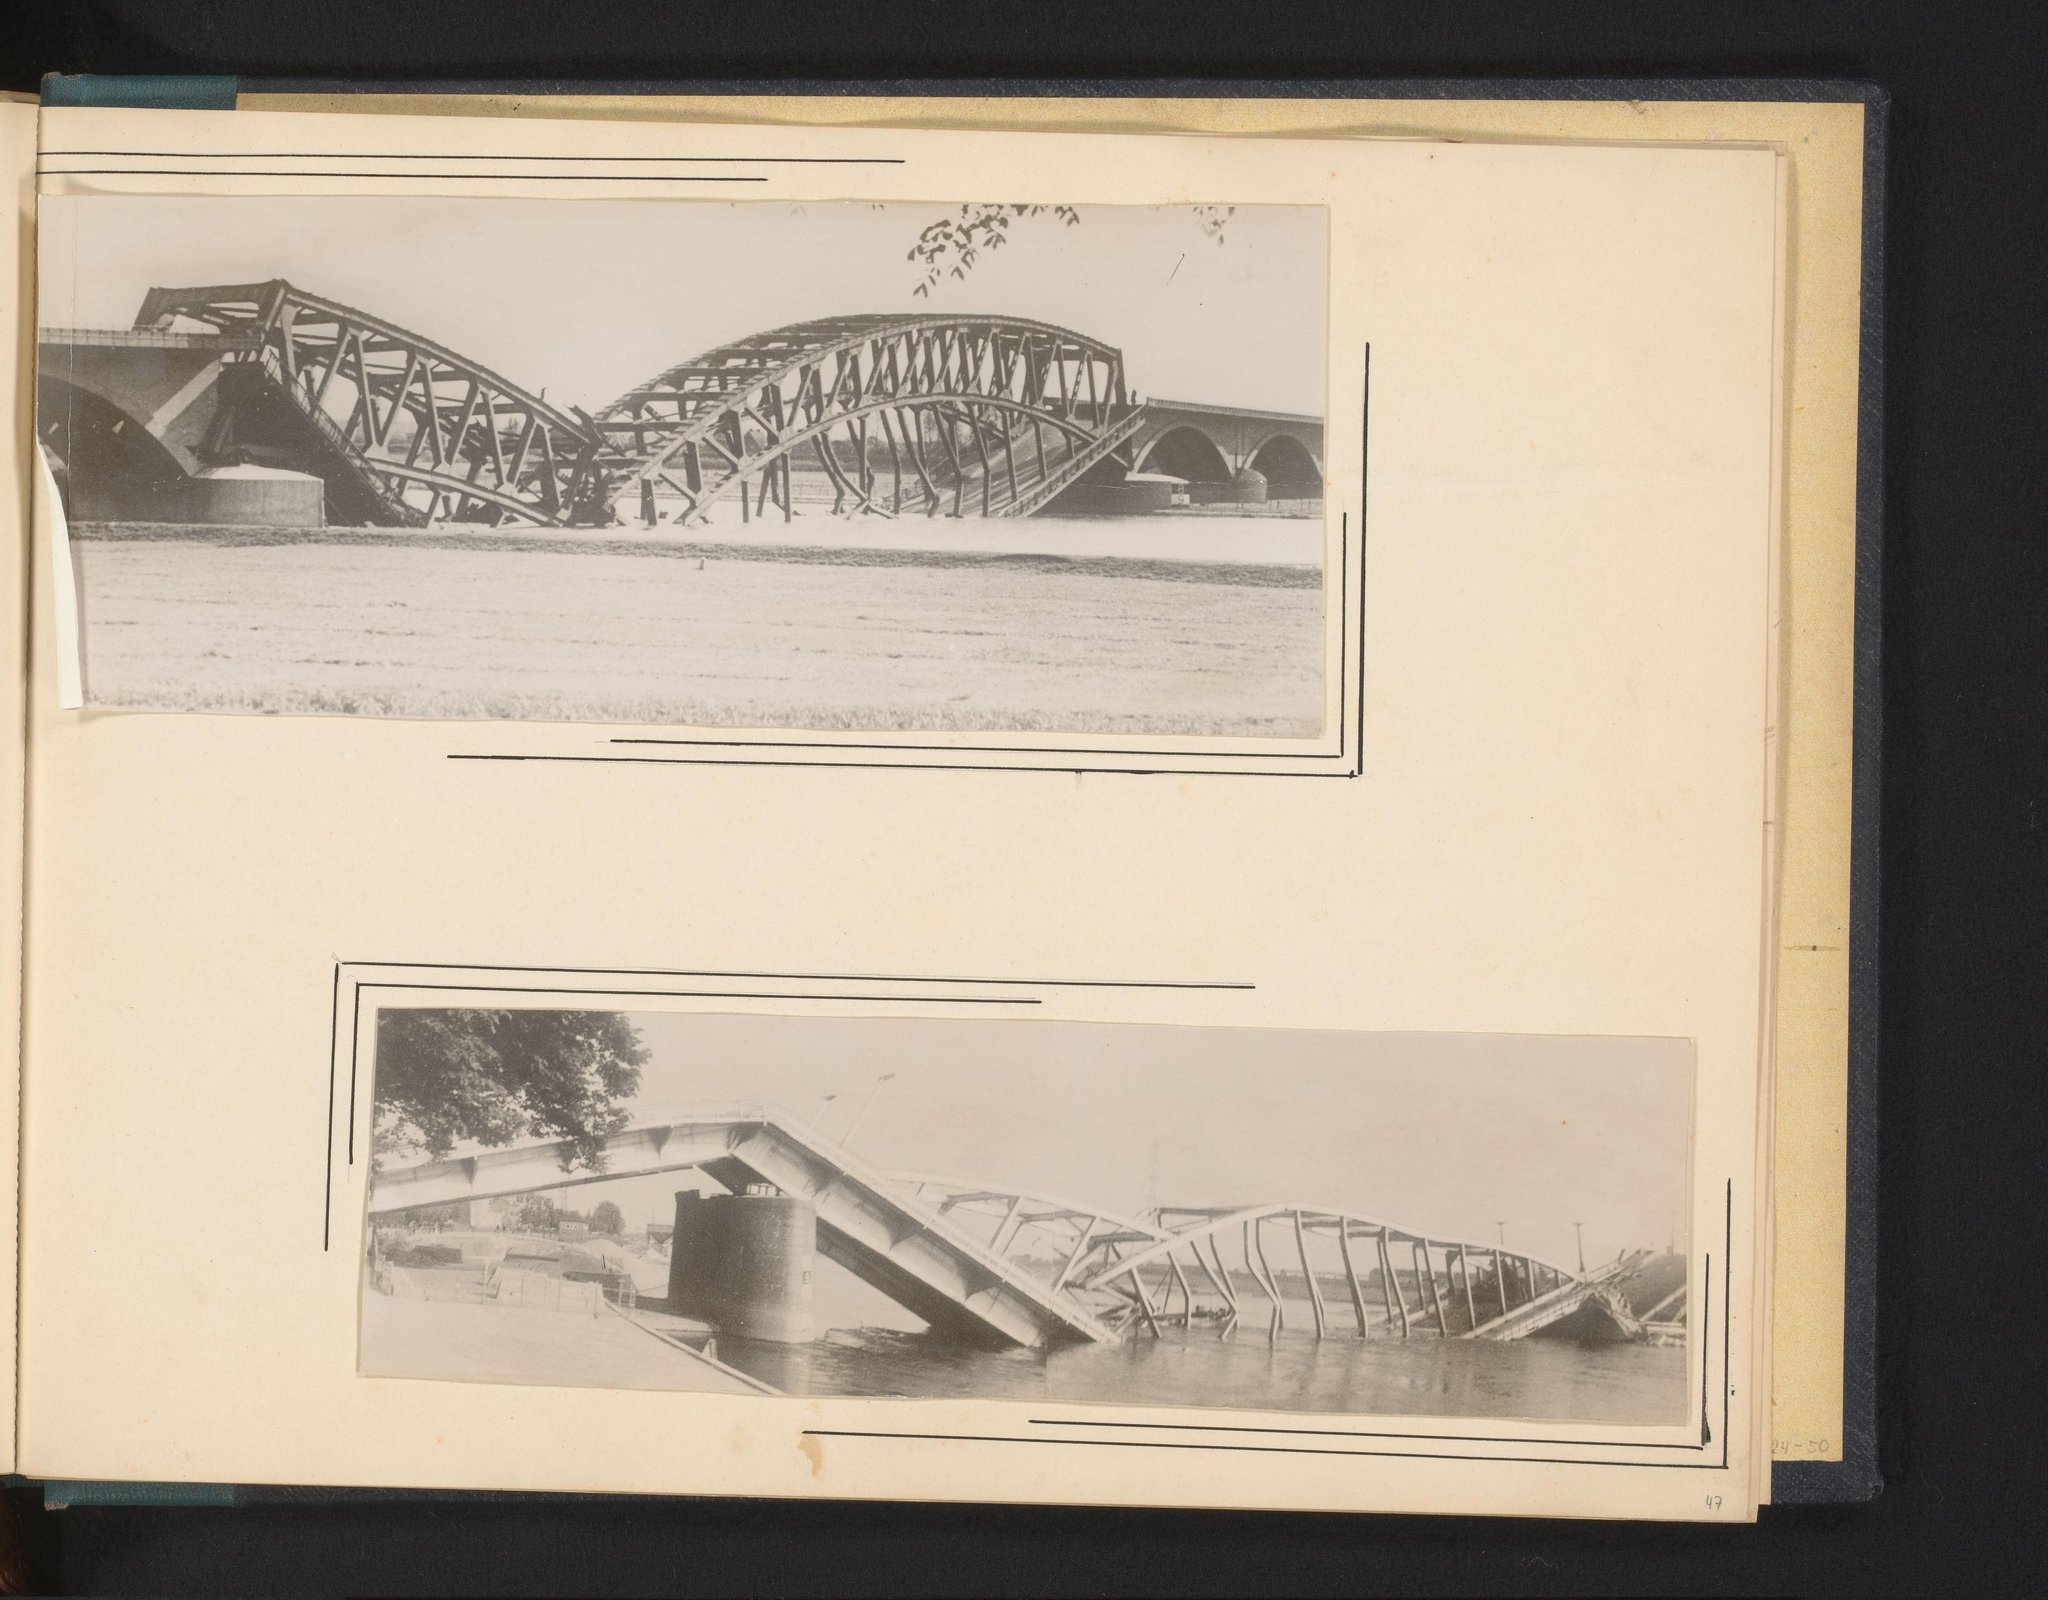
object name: photograph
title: Nijmegen en Arnhem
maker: Anonymous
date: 1940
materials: cardboard, photographic support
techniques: gelatin silver print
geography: rhenen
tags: obstructions, barricades (defensive measures), bridge, nijmegen, arnhem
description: Albumblad met twee foto's van de door het Nederlandse leger opgeblazen bruggen over de Waal bij Nijmegen en de Rijn bij Arnhem, bij de Duitse inval in mei 1940. Onderdeel van het fotoalbum over de verwoestingen van Nederlandse steden en infrastructuur in het begin van de Tweede Wereldoorlog.